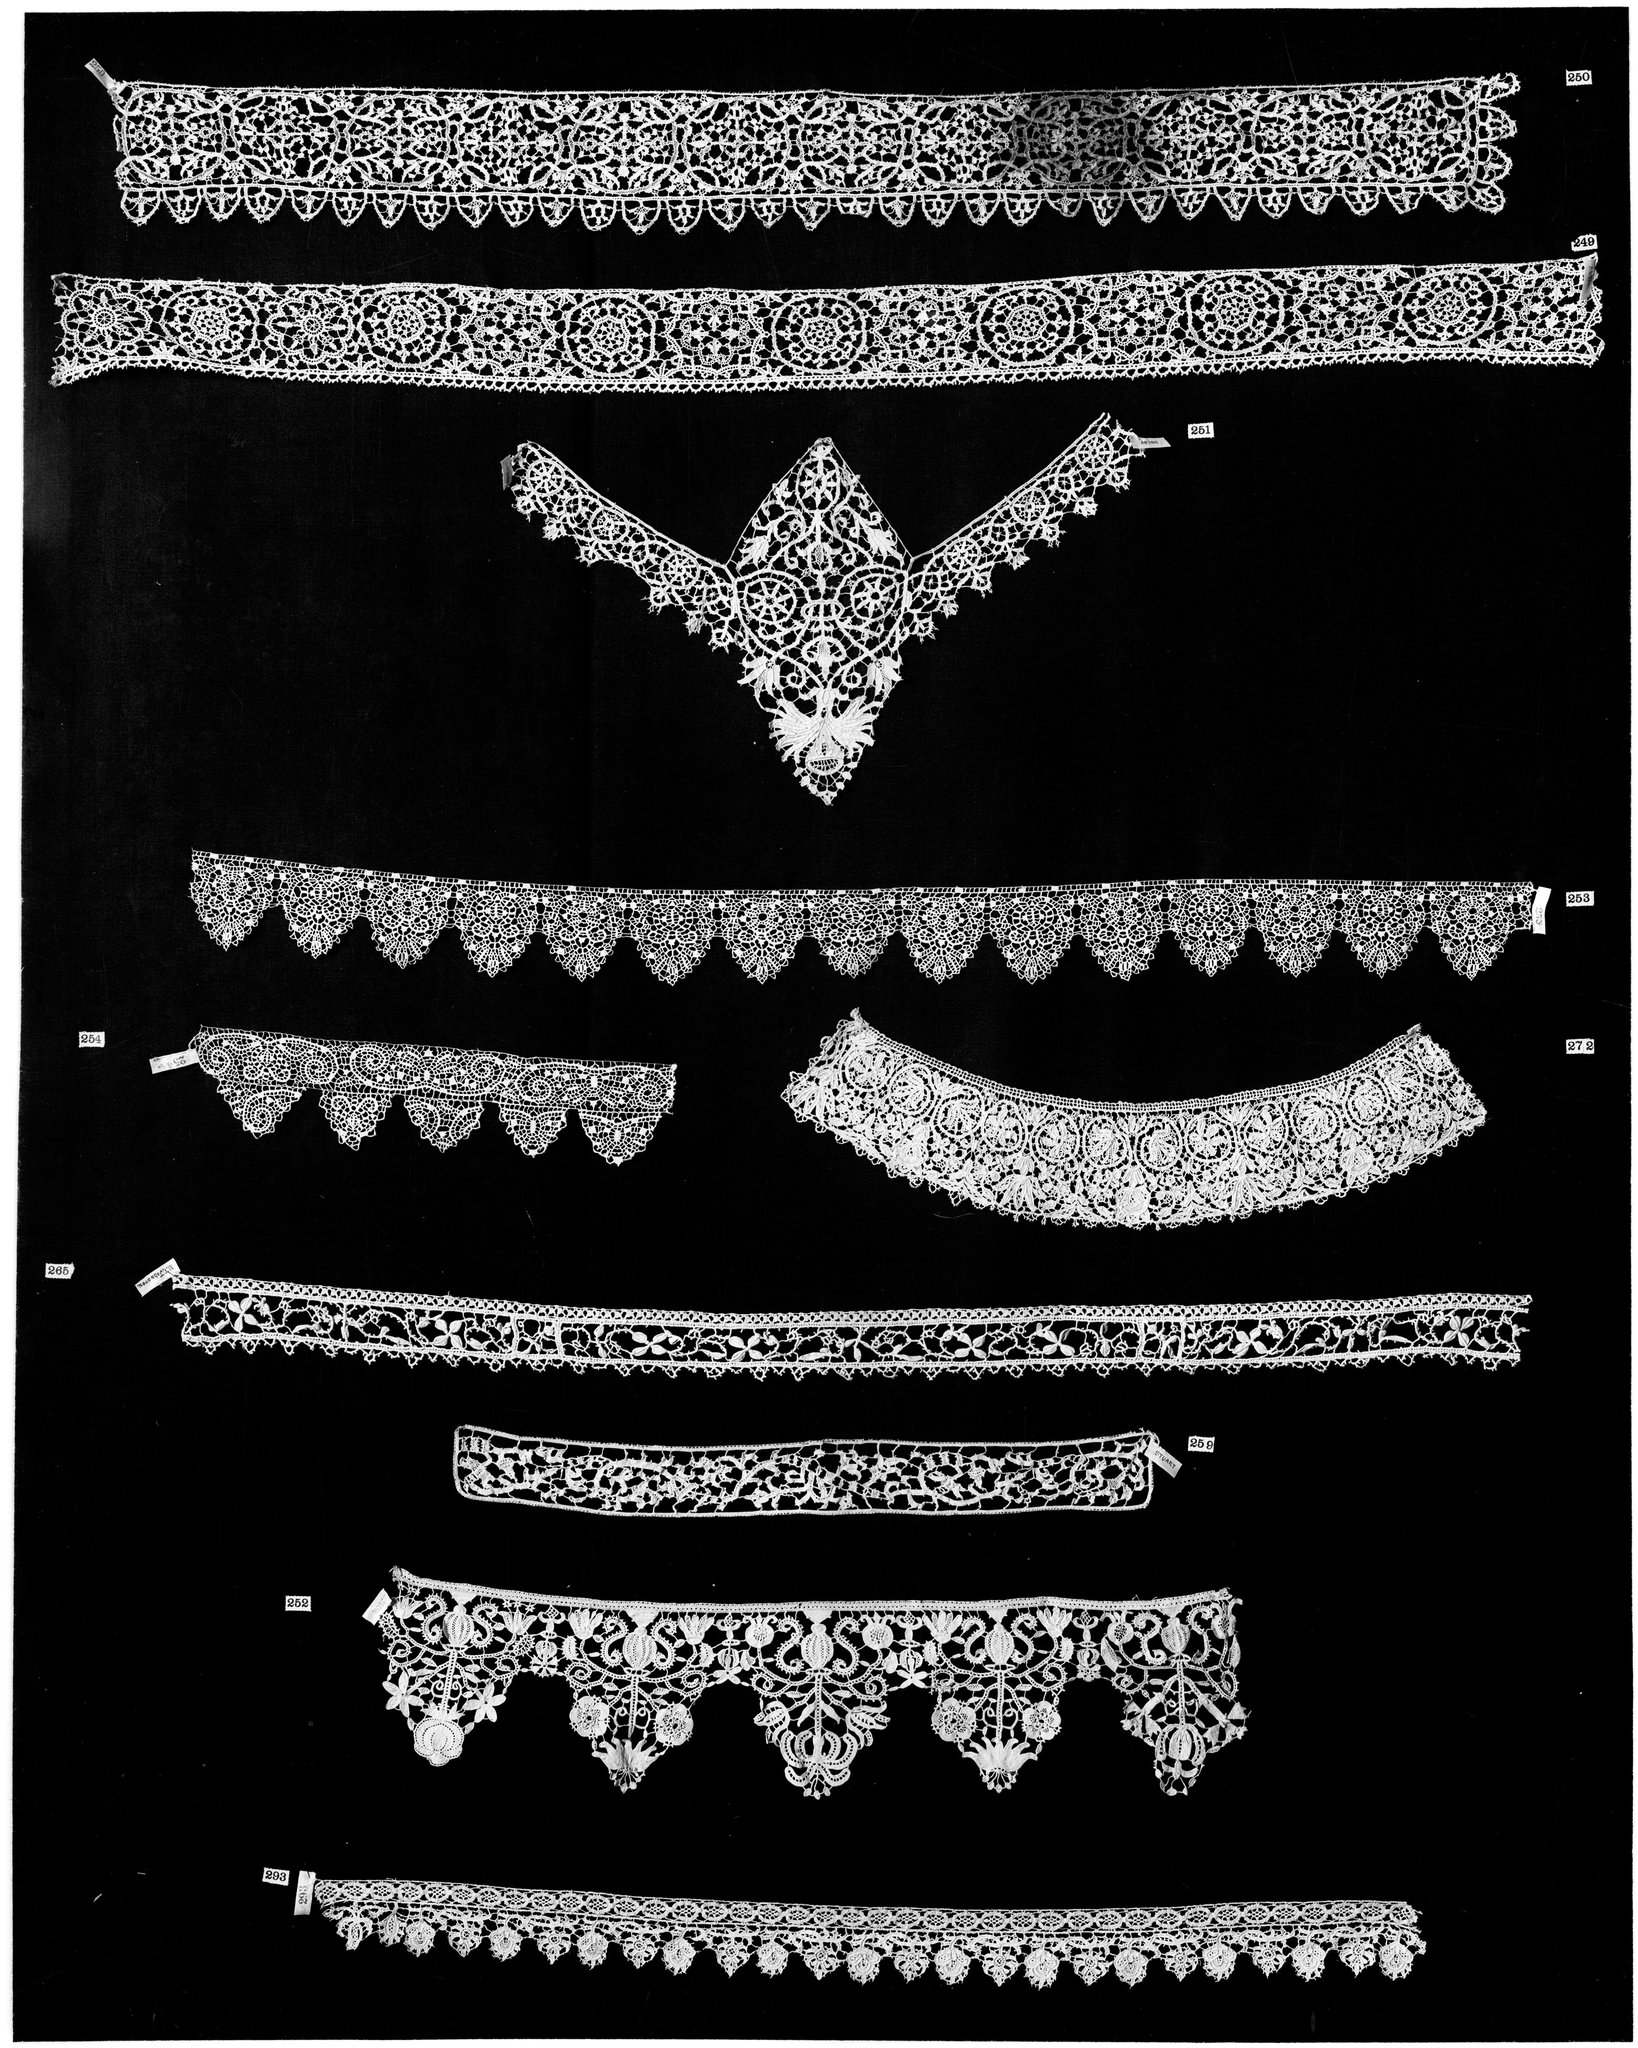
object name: fragment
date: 1601-1625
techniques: lace